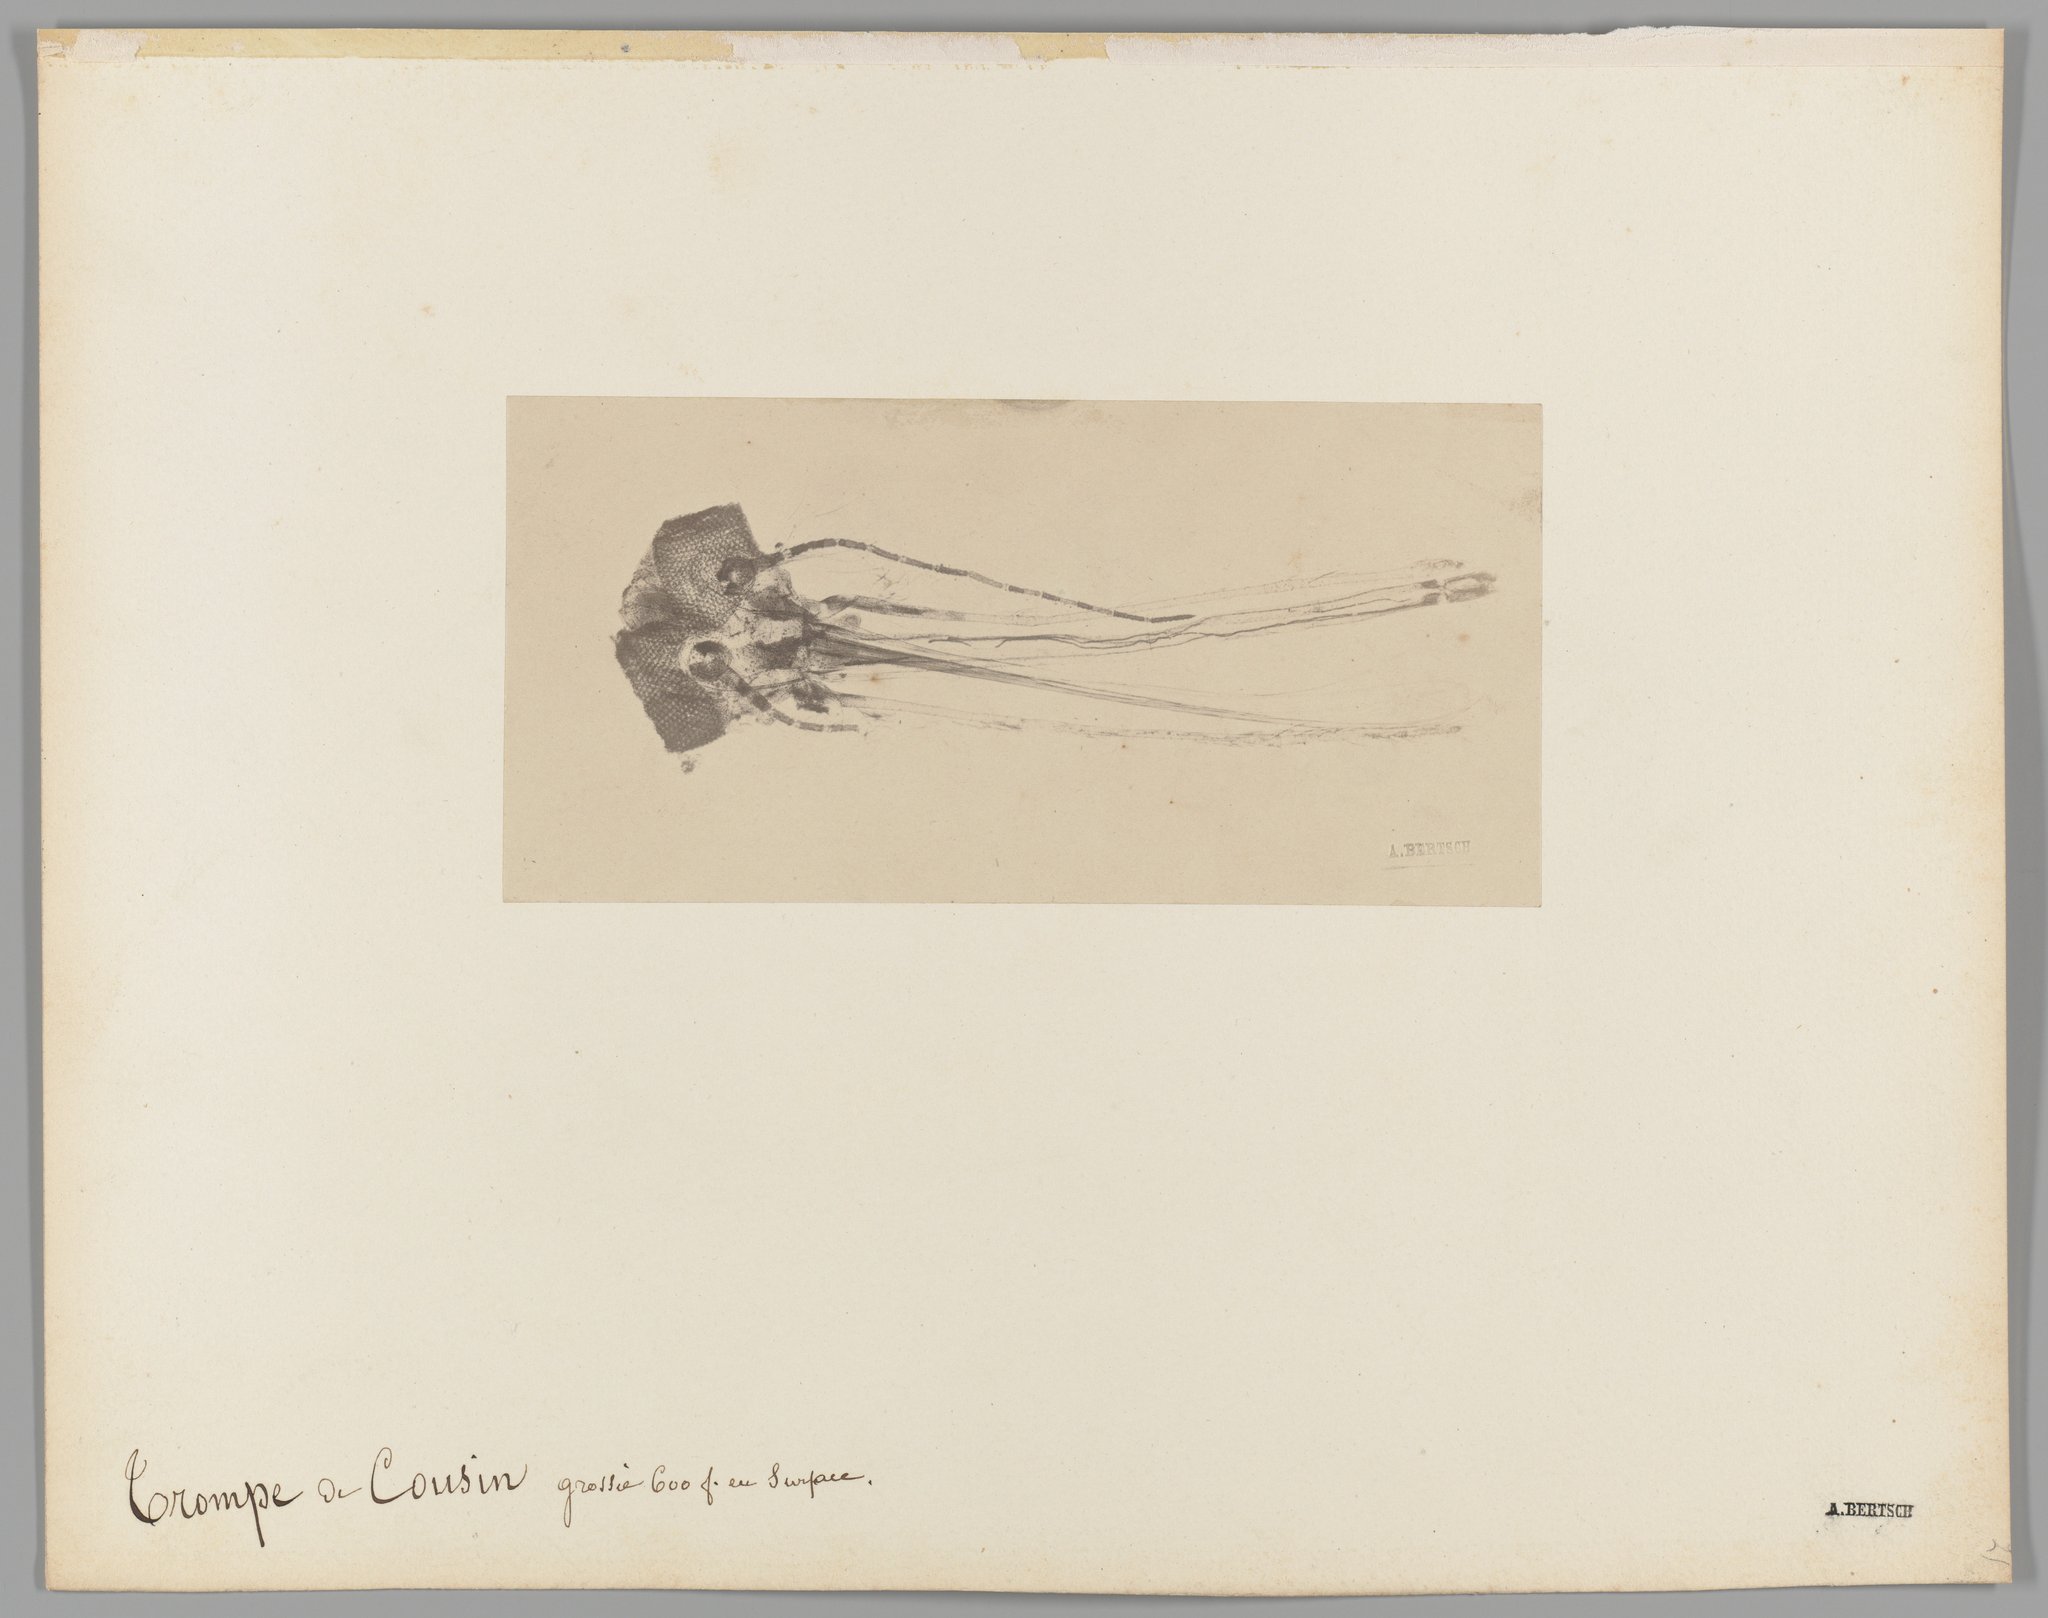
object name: photograph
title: [Untitled]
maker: auguste-adolphe bertsch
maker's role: artist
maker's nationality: french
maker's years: 1813-1871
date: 1853-1857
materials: photographic print